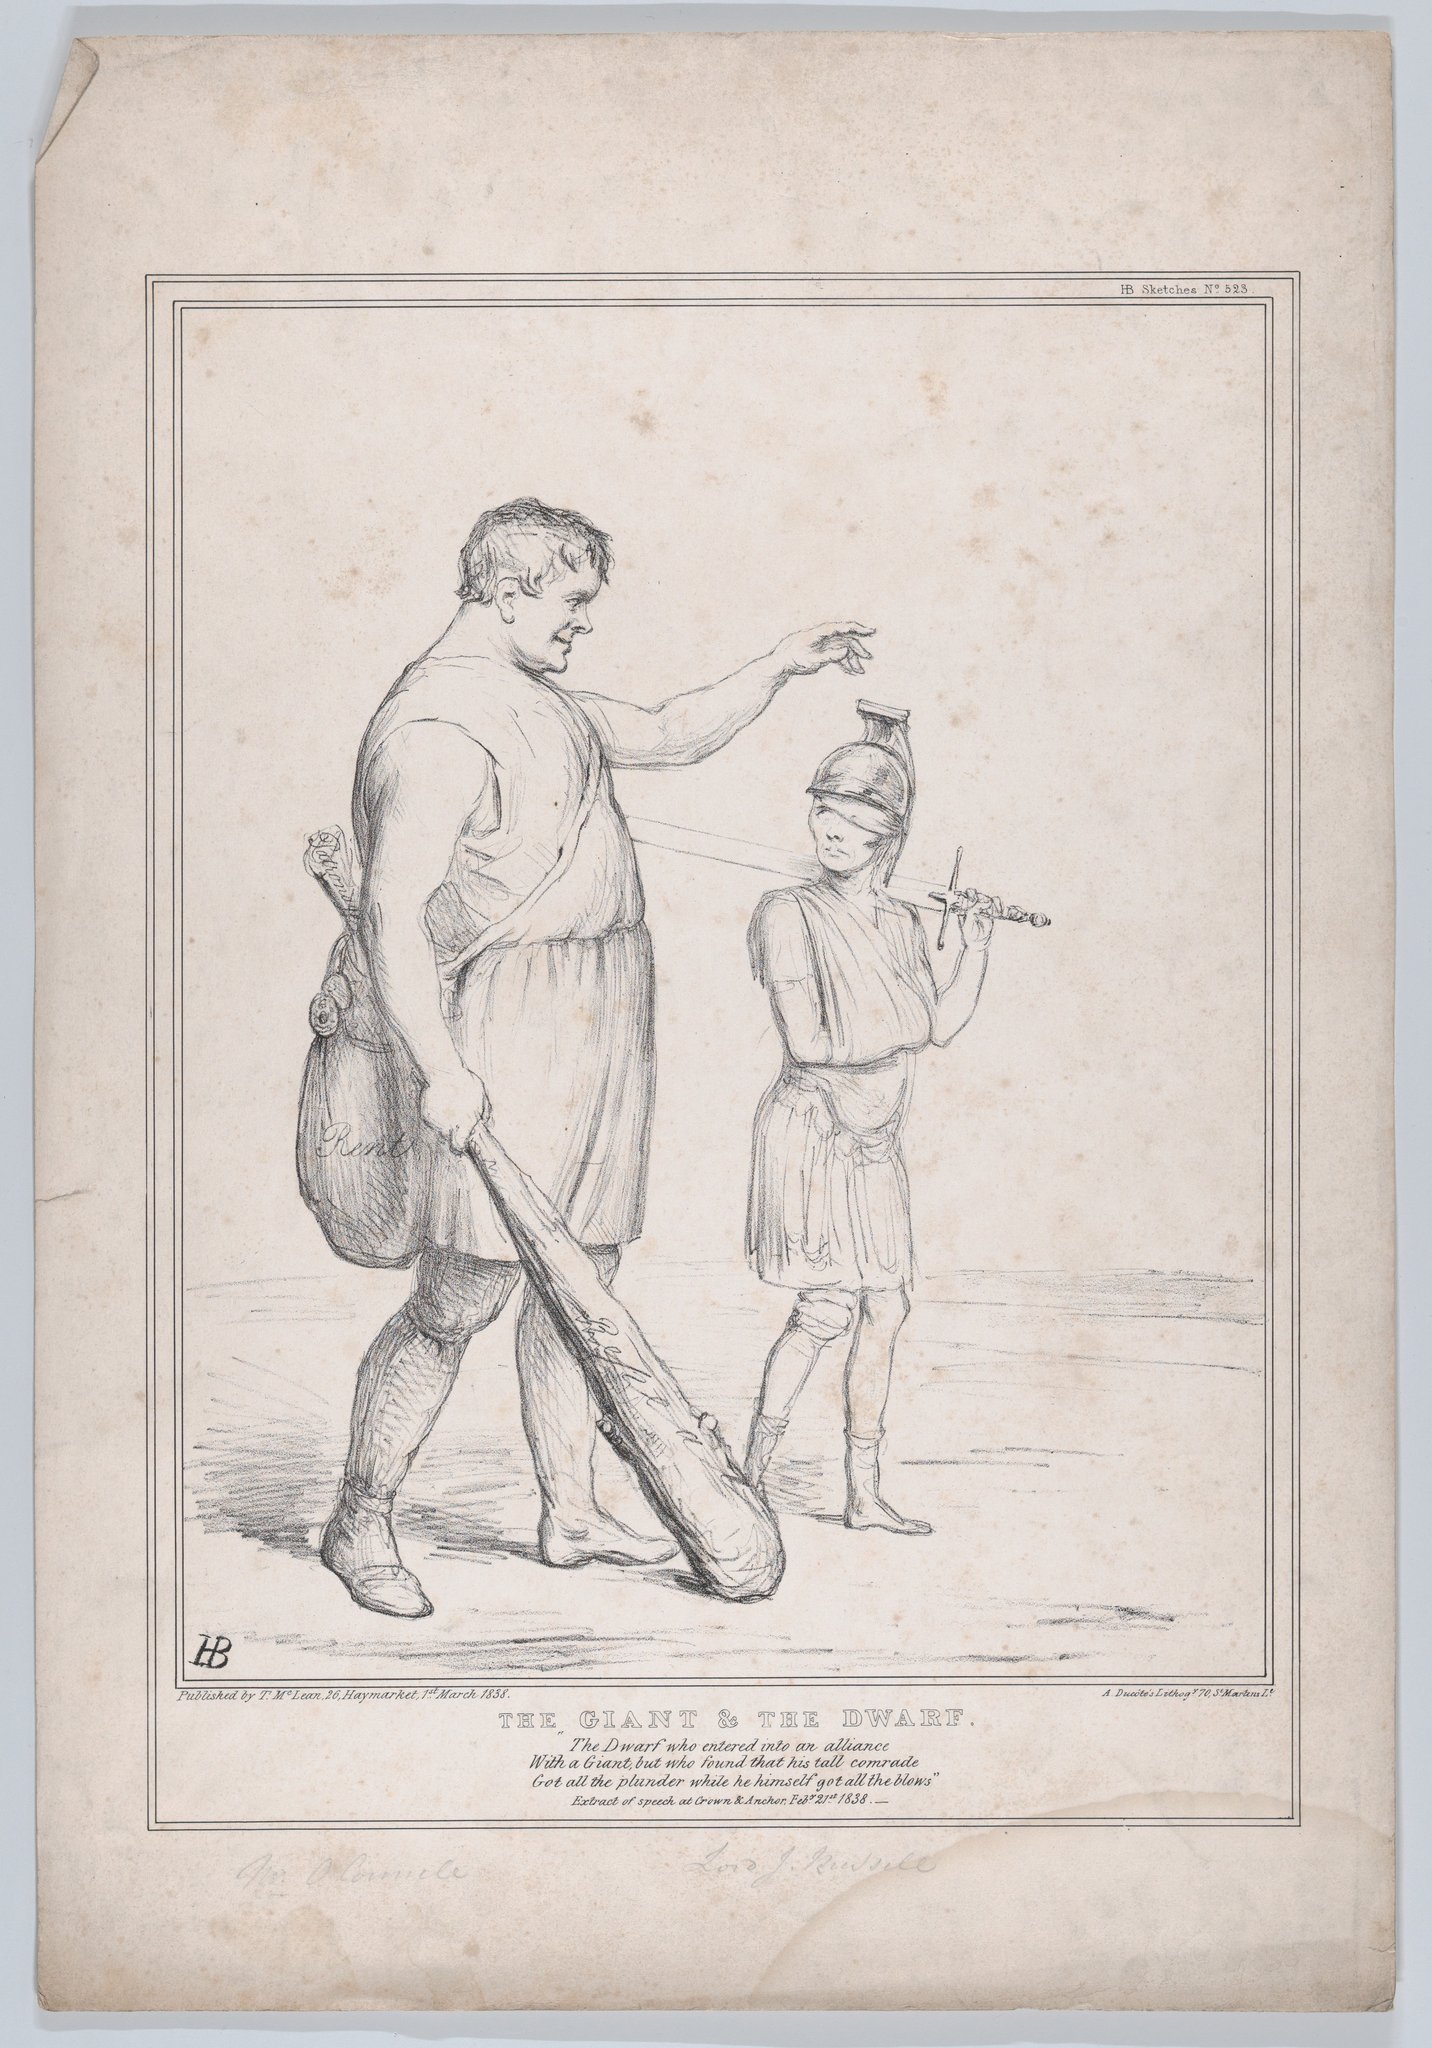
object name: print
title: The Giant & the Dwarf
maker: john doyle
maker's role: artist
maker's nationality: irish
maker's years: 1797-1868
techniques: lithograph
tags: satire,swords,men